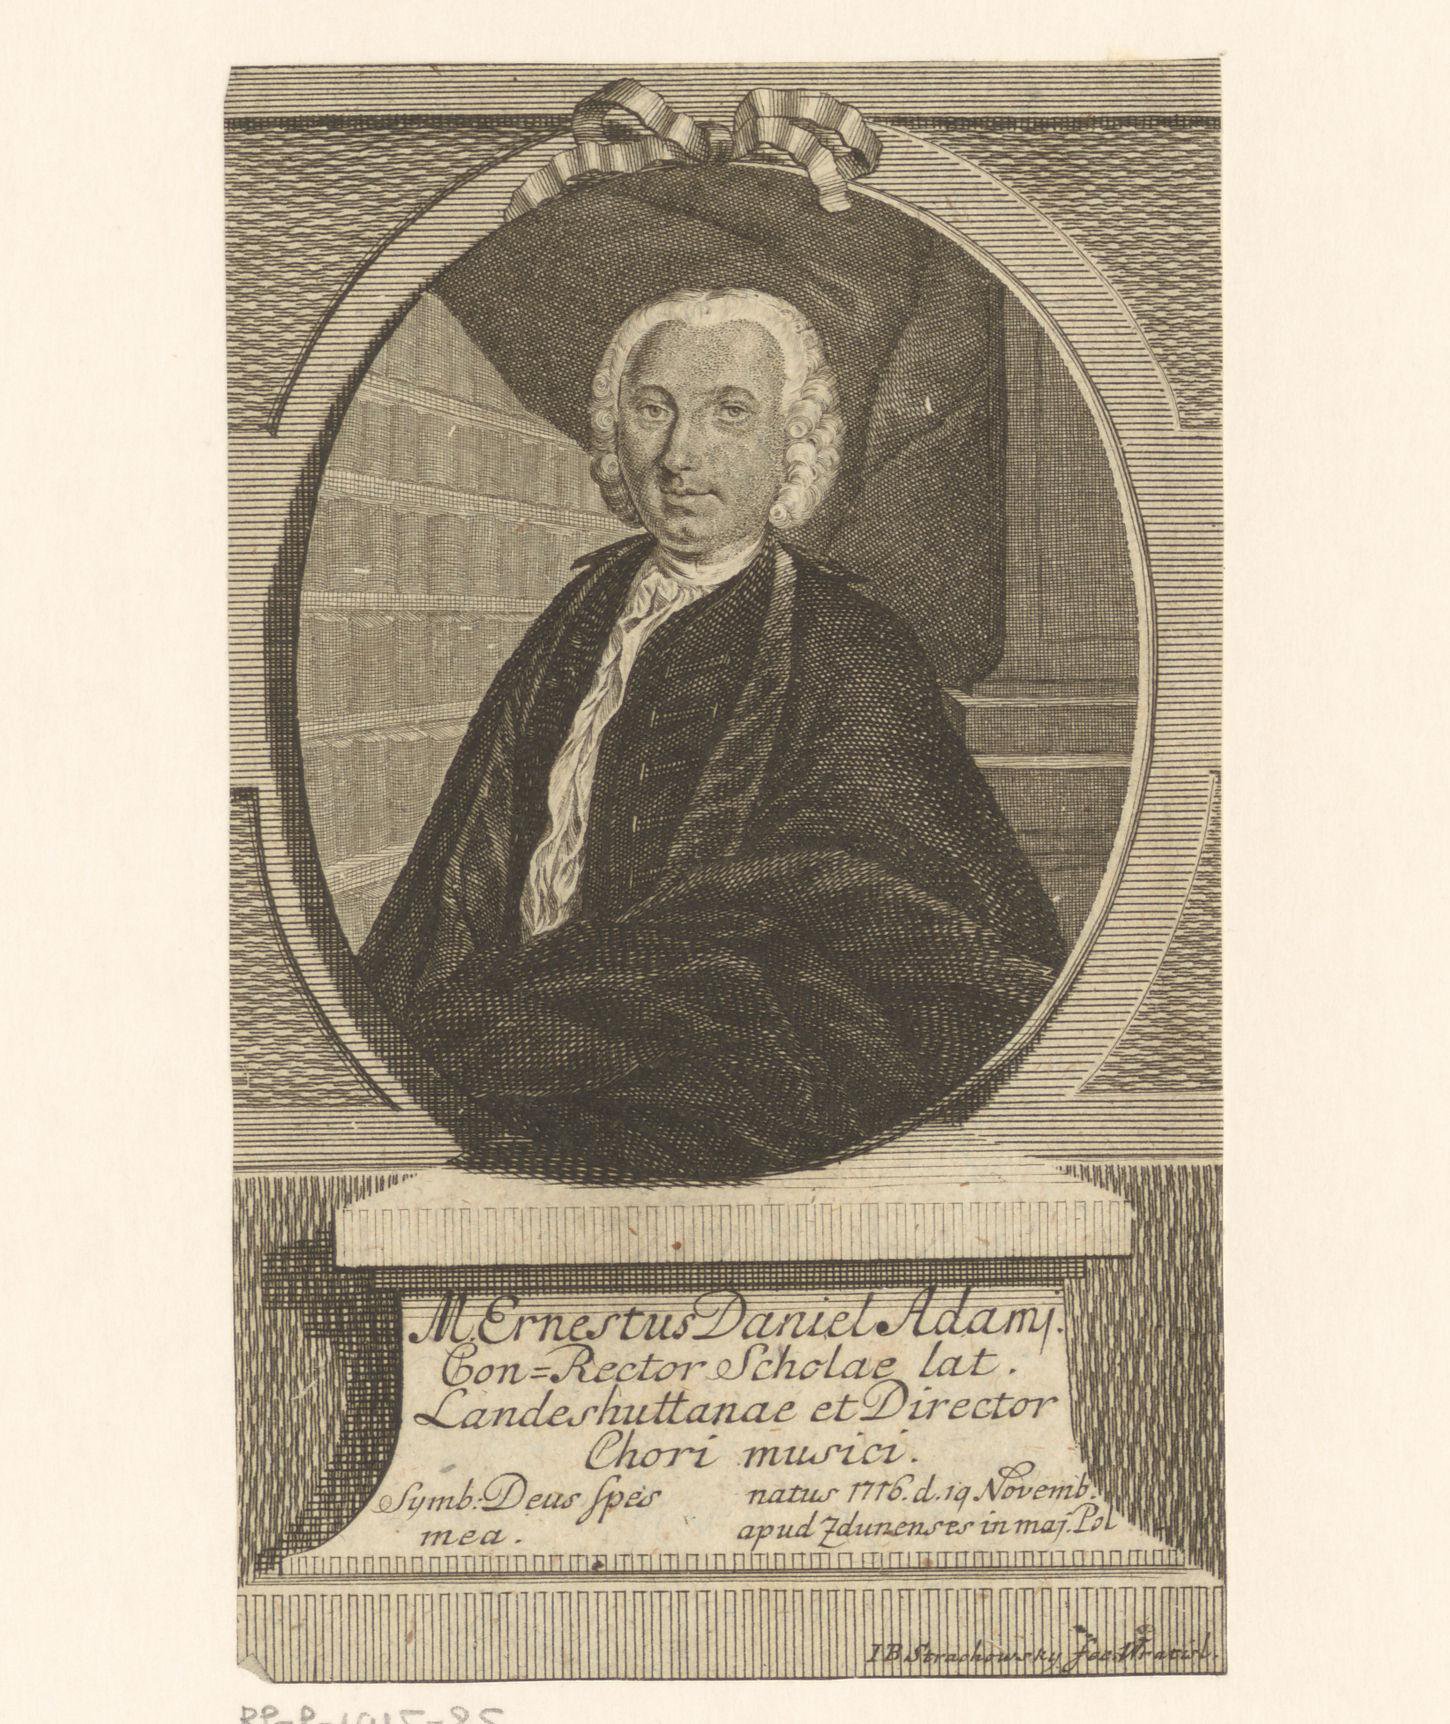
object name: print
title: Portret van Ernst Daniel Adami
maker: johann bartholomäus strahowsky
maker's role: print maker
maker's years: -1790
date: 1745-1790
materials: paper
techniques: engraving, etching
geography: breslau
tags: bookshelves, historical persons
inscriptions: collector's mark: Lugt 2228